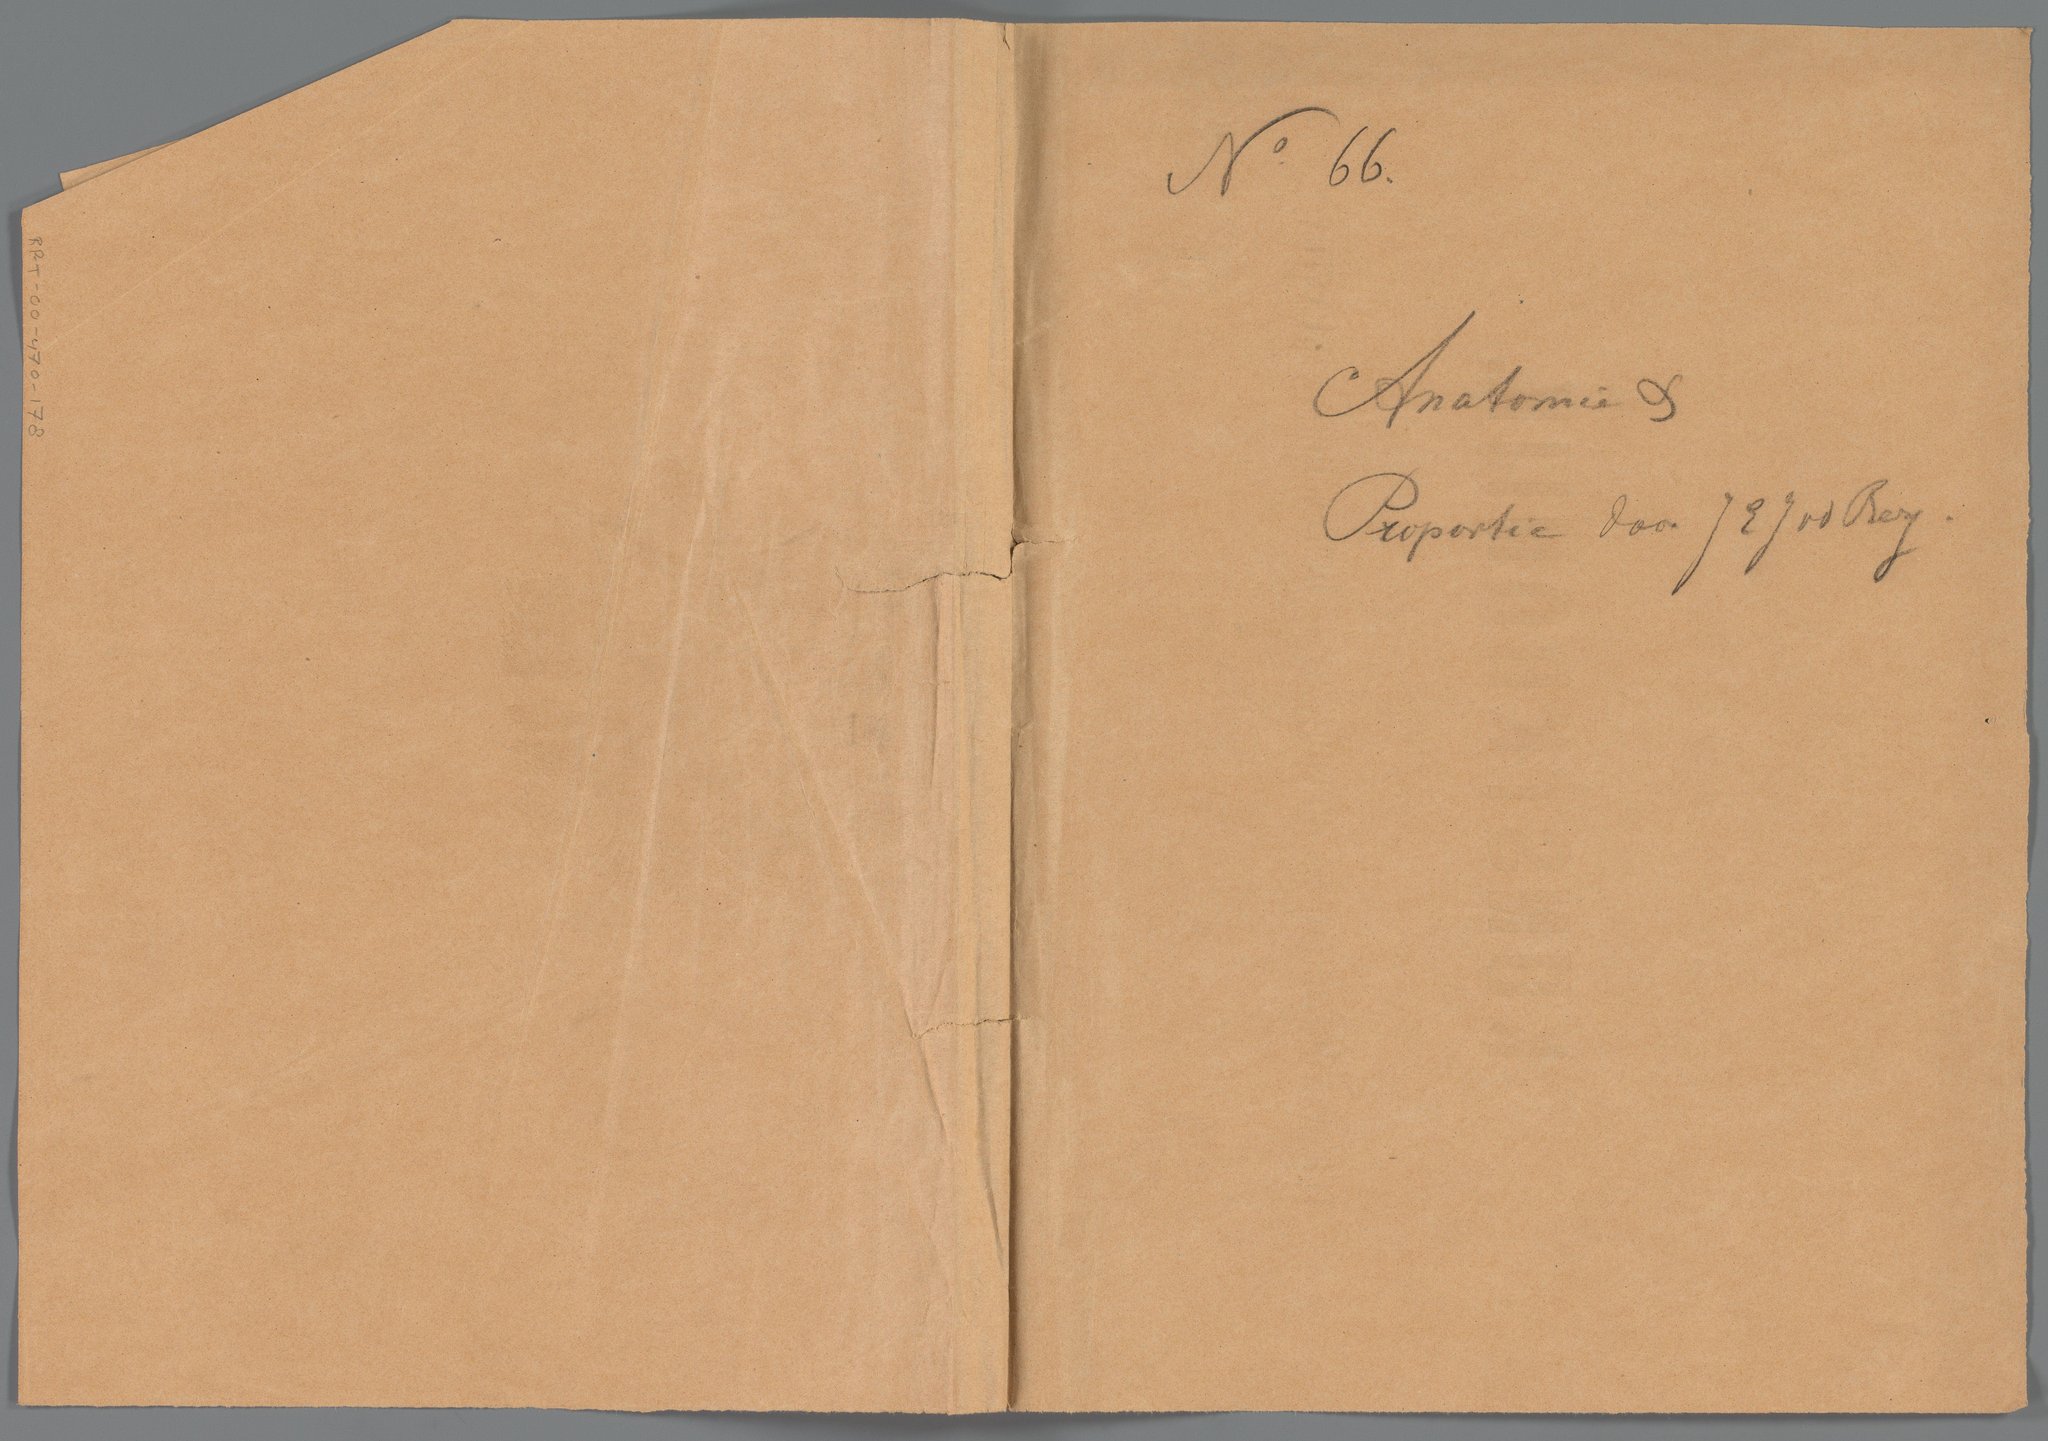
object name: print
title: Titelpagina voor: Kunstkronijk, 1868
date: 1868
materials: paper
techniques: letterpress printing, engraving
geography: leiden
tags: tools, implements of painter, book, decorating 'en relief', appliquéing, lute, and special forms of lute, e.g.: theorbo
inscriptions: inscription: ‘No. 66/ Anatomie &/ Proportie door J.E.J. vd Berg.’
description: Met vignet van een reliëf met daarvoor een schilderspalet, een luit, een kan en boeken.